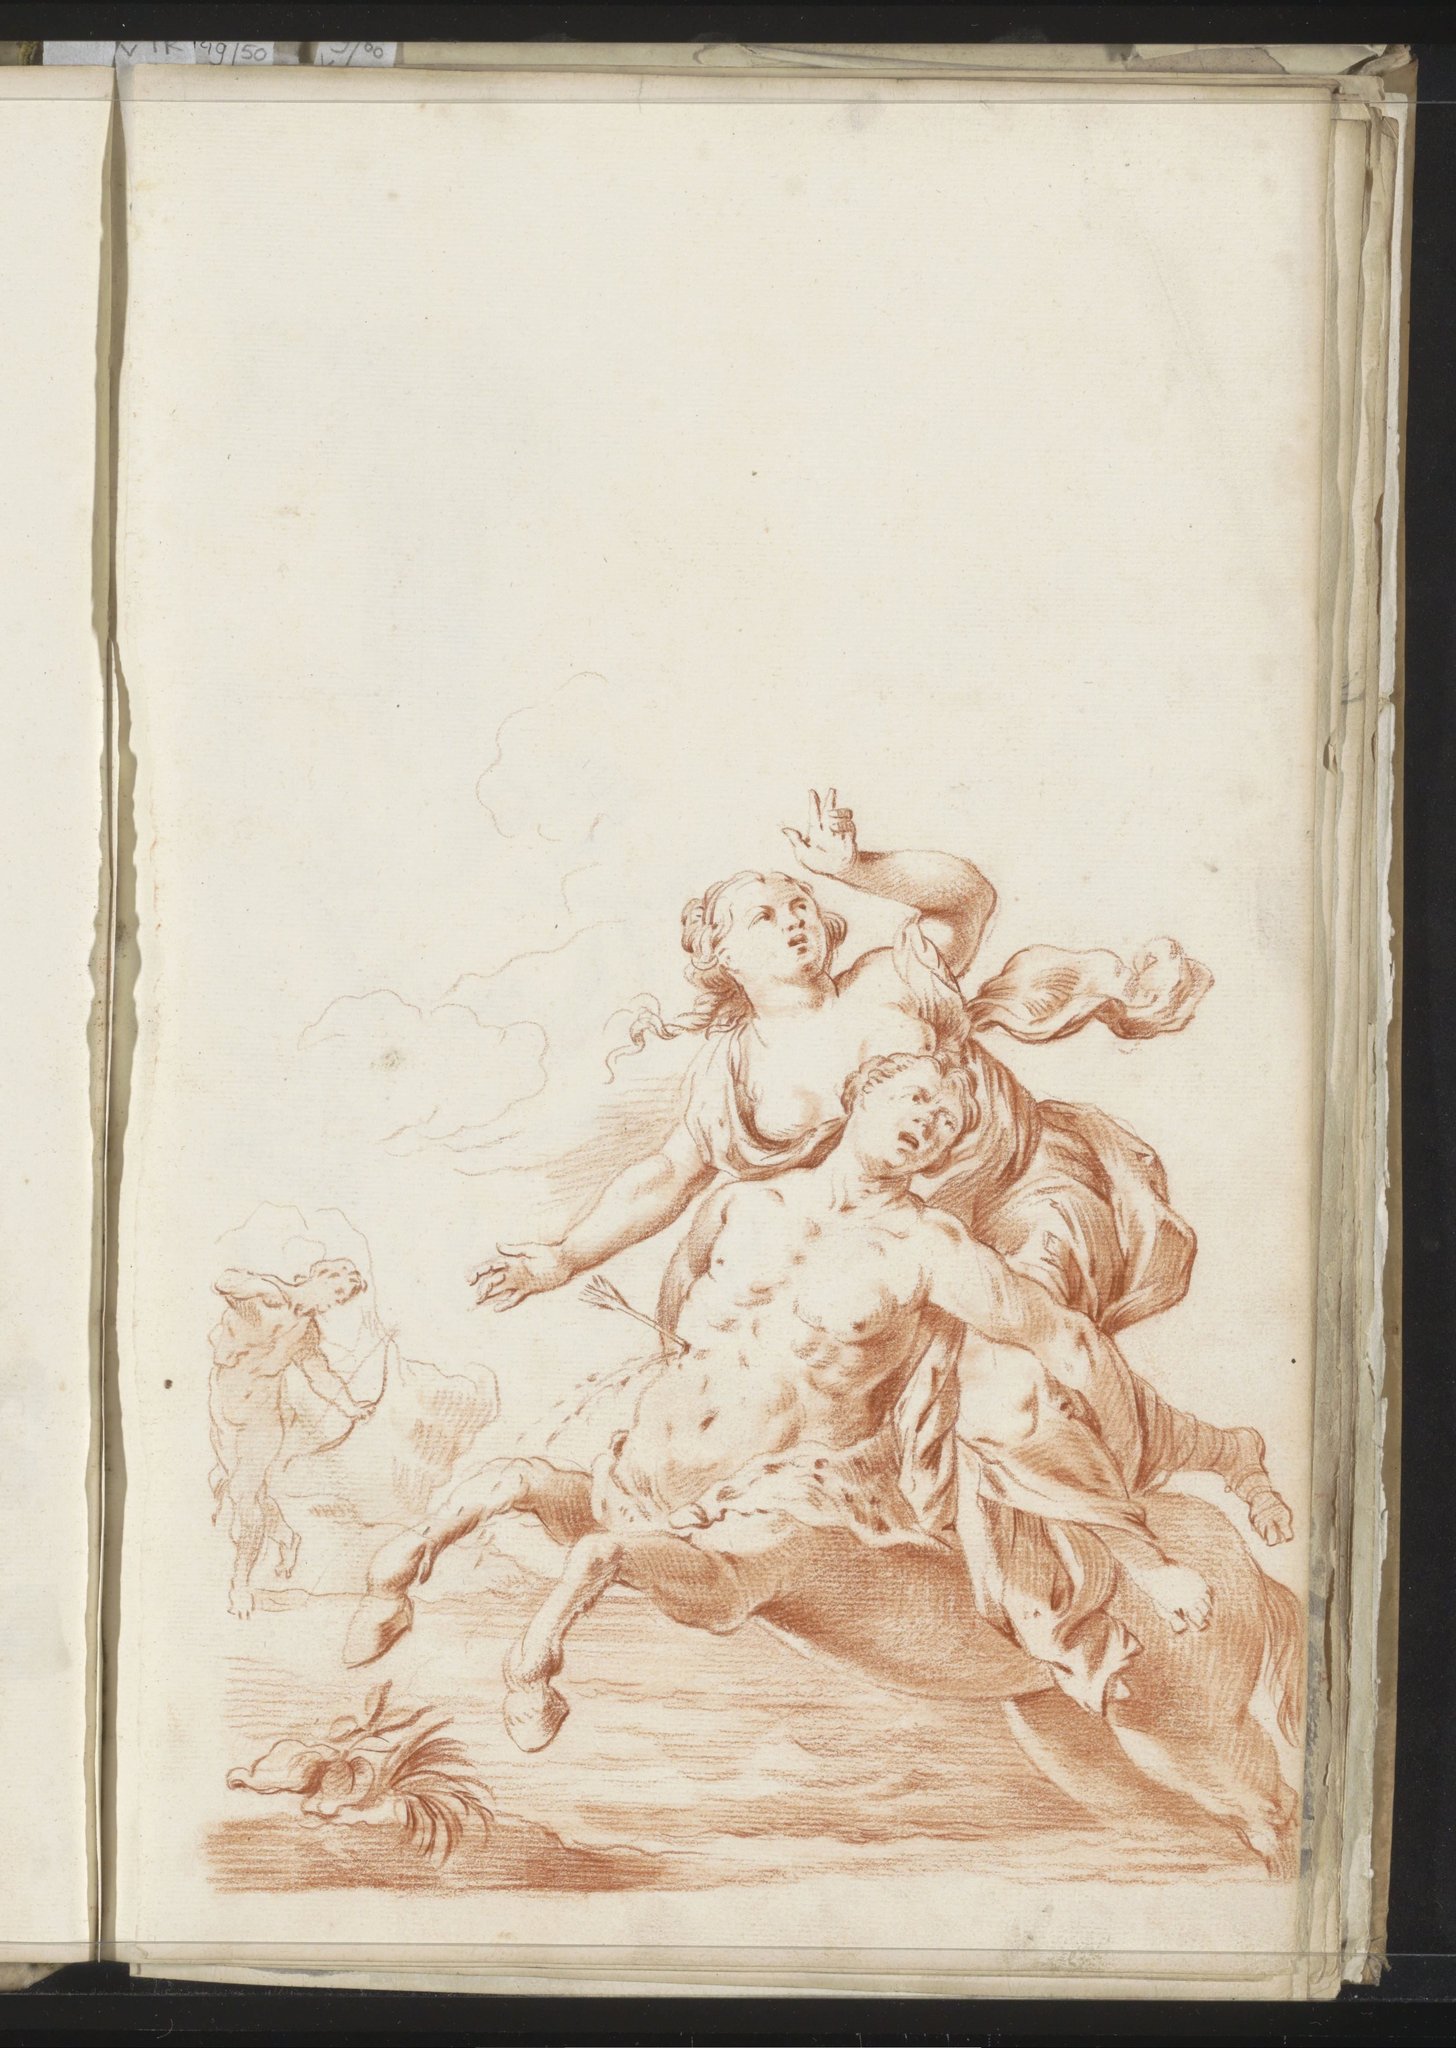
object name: sketchbook leaf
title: Roof van Hippodamea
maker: jacob toorenvliet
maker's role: draughtsman, painter, print maker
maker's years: 1640-1719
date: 1701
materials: chalk, paper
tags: the centaur eurytion tries to carry off hippodamia, the bride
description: De centaur Eurytus probeert de bruid Hippodamea op zijn rug te ontvoeren. Op de achtergrond een man met een pijl en boog die de centaur in de buik heeft geschoten. Blad 44 recto uit een schetsboek met 63 bladen.